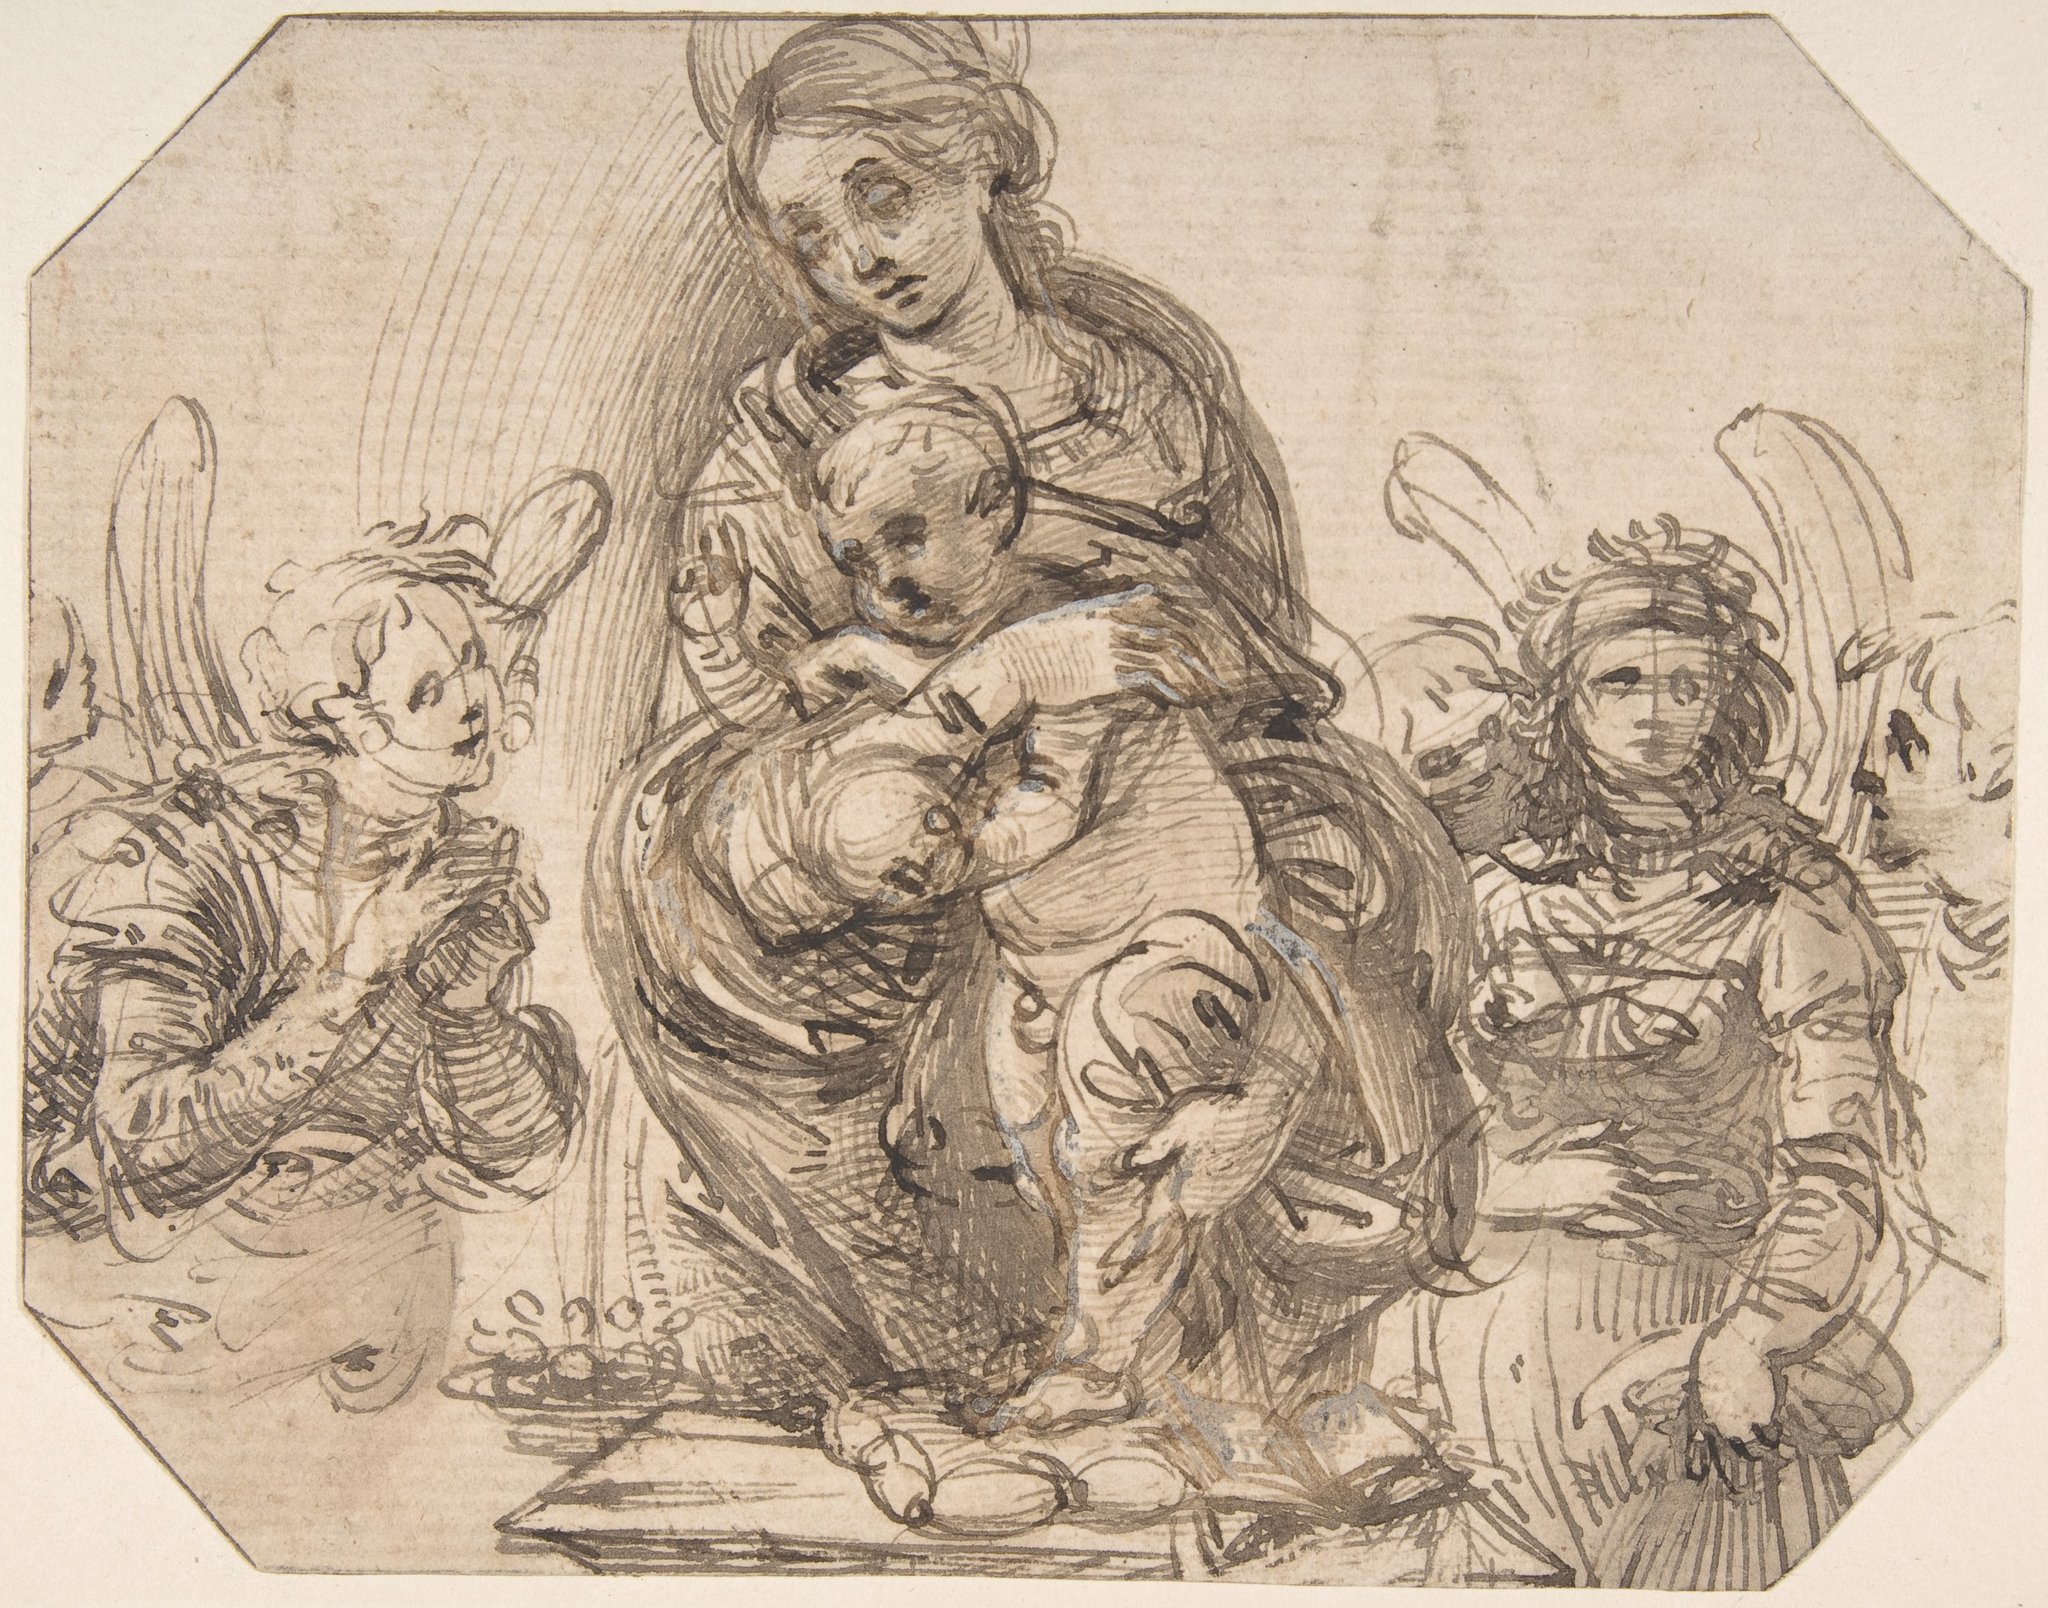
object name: drawing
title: Virgin and Child Attended by Angels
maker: filippino lippi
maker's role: artist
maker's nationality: italian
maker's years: 1457-1504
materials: gouache, ink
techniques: brush, highlighting, pen, wash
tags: angels,madonna and child